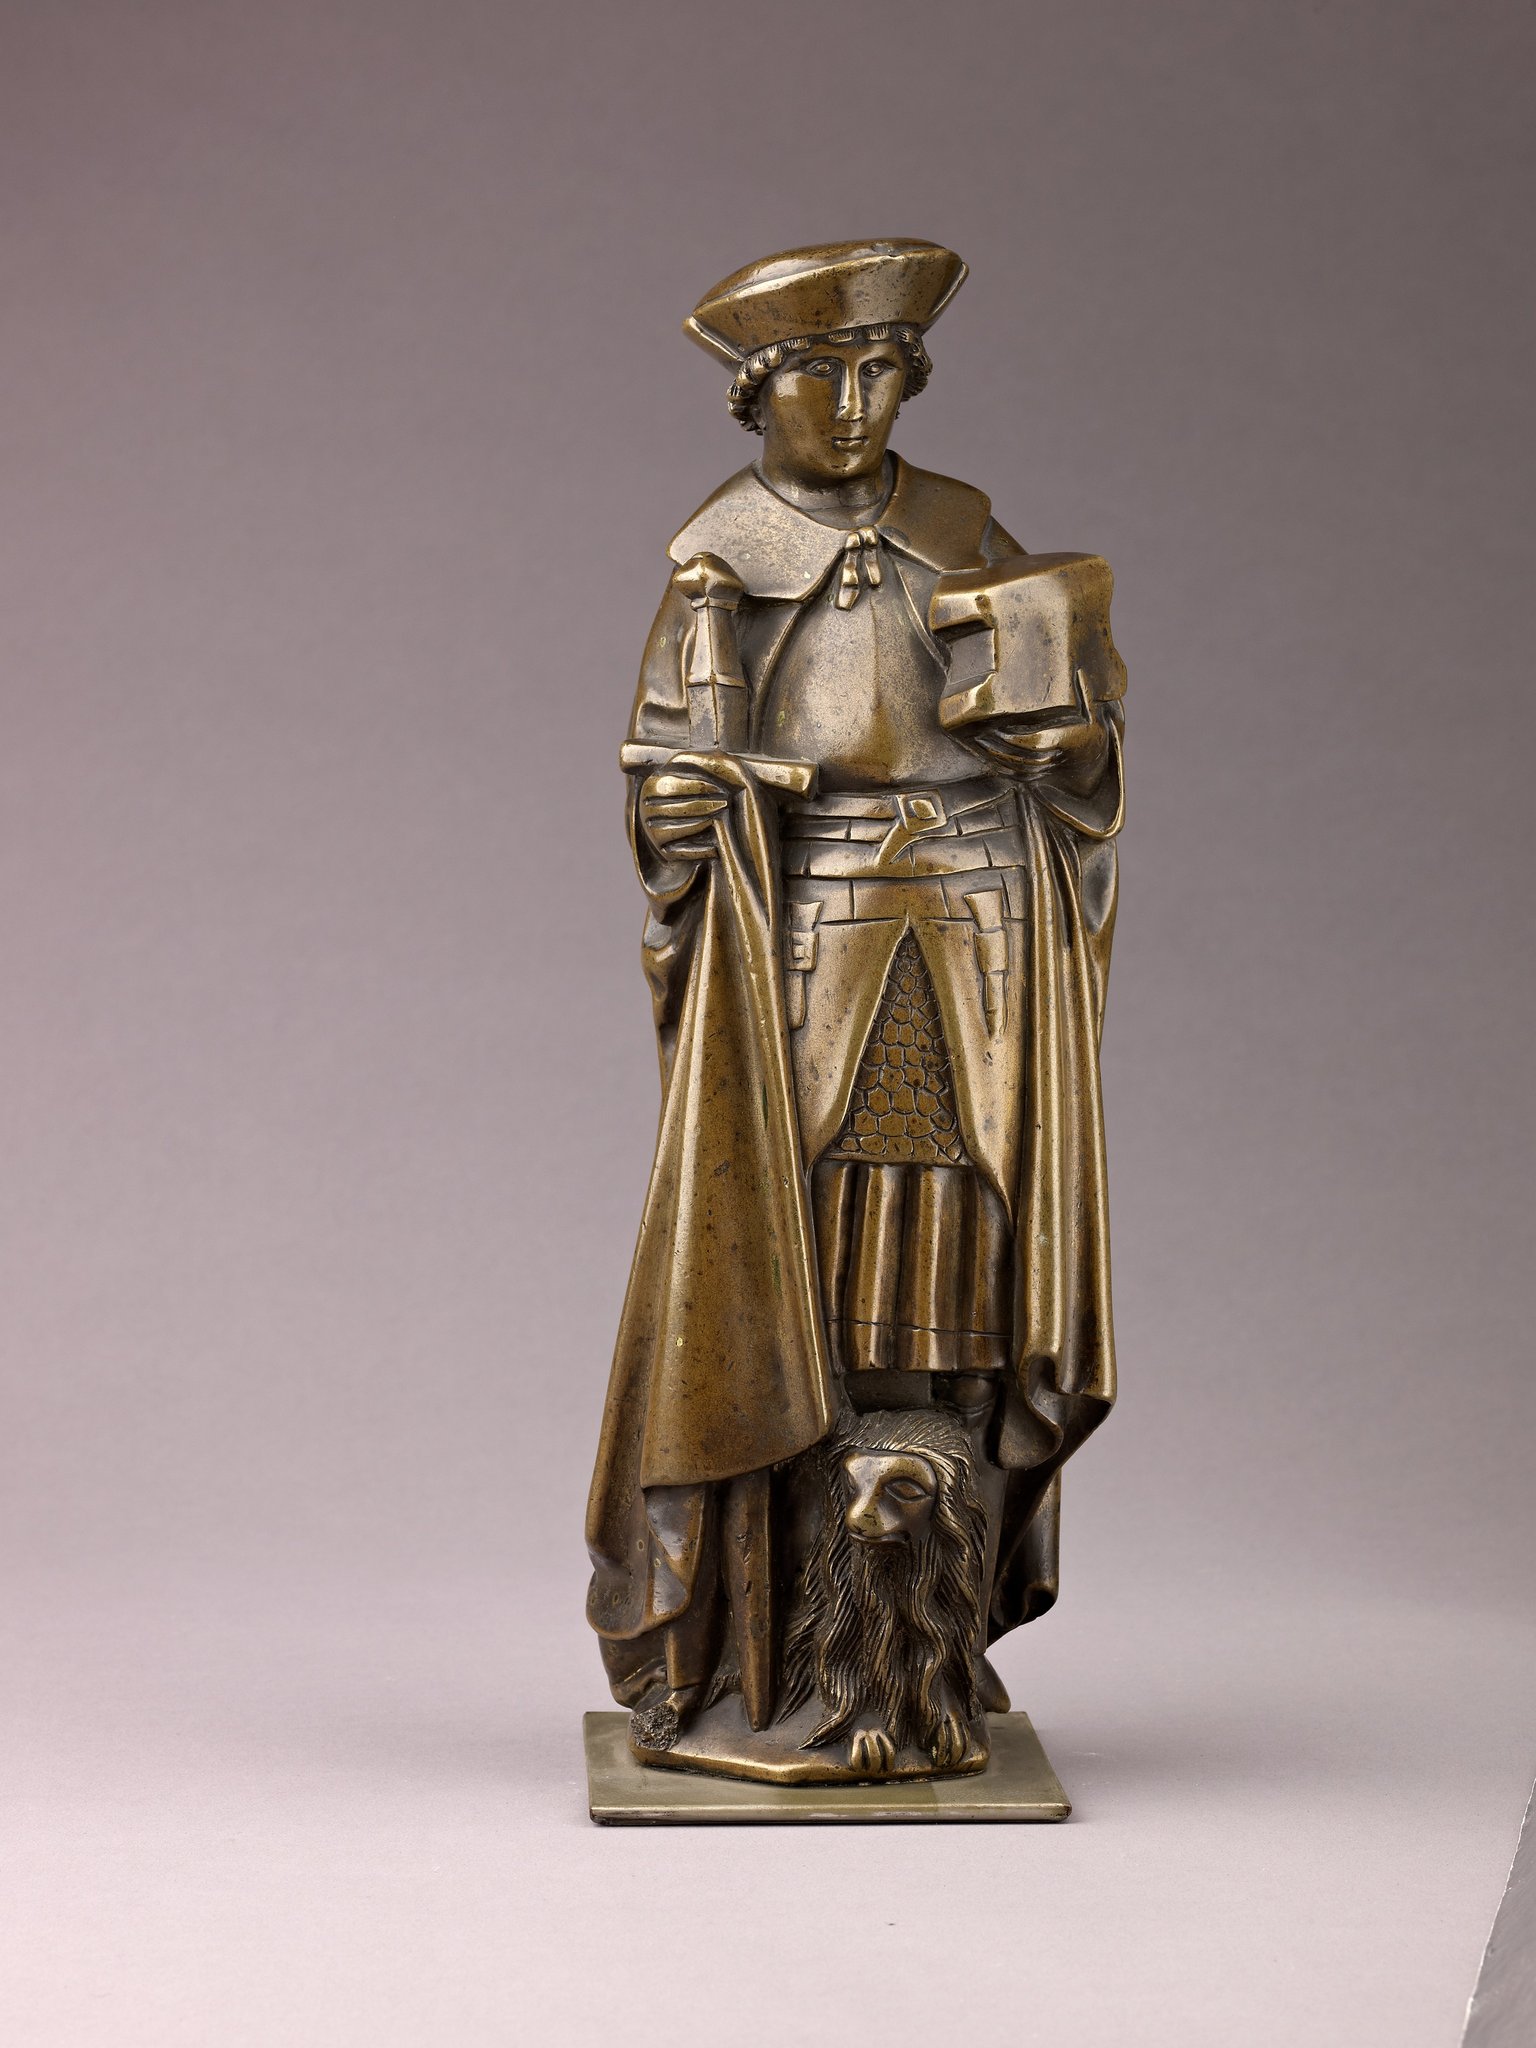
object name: sculpture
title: Saint Adrian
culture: dutch, tournai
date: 1451-1475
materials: brass, patina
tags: men,saints